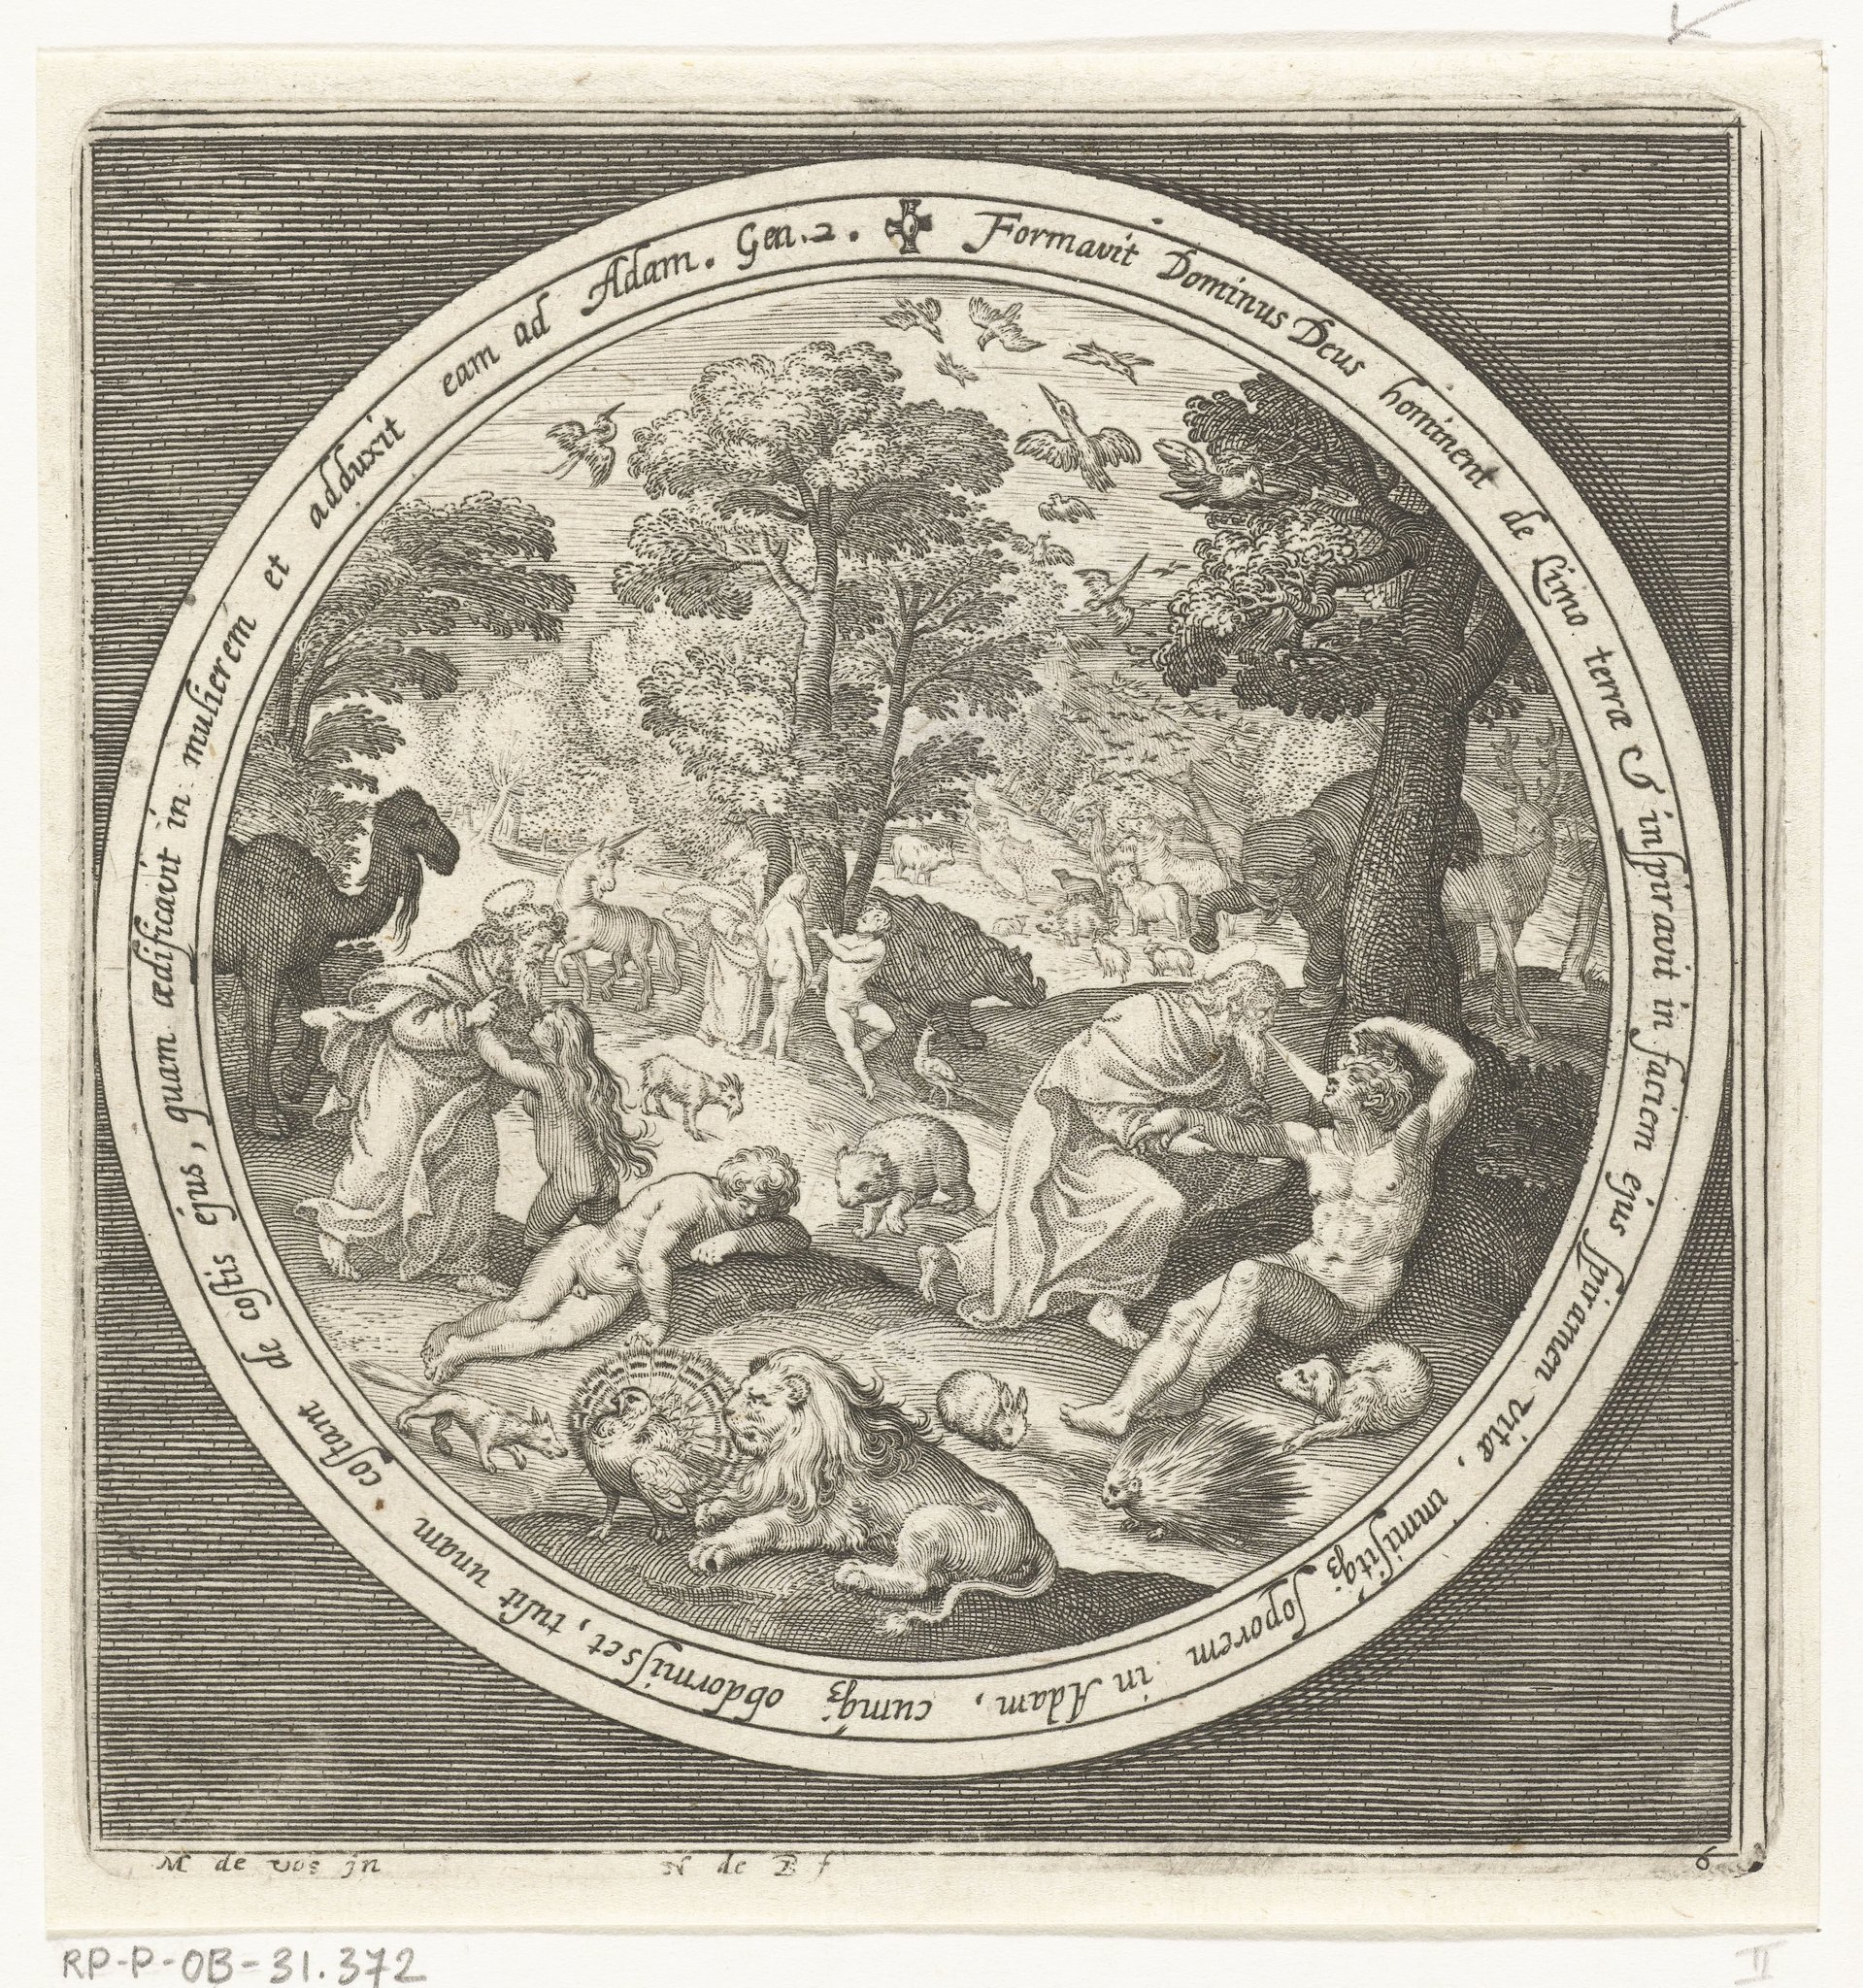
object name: print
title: Van schepping tot verdrijving uit paradijs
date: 1581-1656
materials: paper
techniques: engraving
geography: netherlands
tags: the man (adam) comes to life: usually god reaches out his hand or breathes life into his nostrils, creation of land-animals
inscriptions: collector's mark: Lugt 2228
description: Zesde dag van schepping: God schept de dieren en Adam en Eva. Hij blaast Adam leven in door zijn neus. In medaillon met als opschrift een bijbeltekst in Latijn uit Genesis 2, binnen rechthoekige omlijsting.